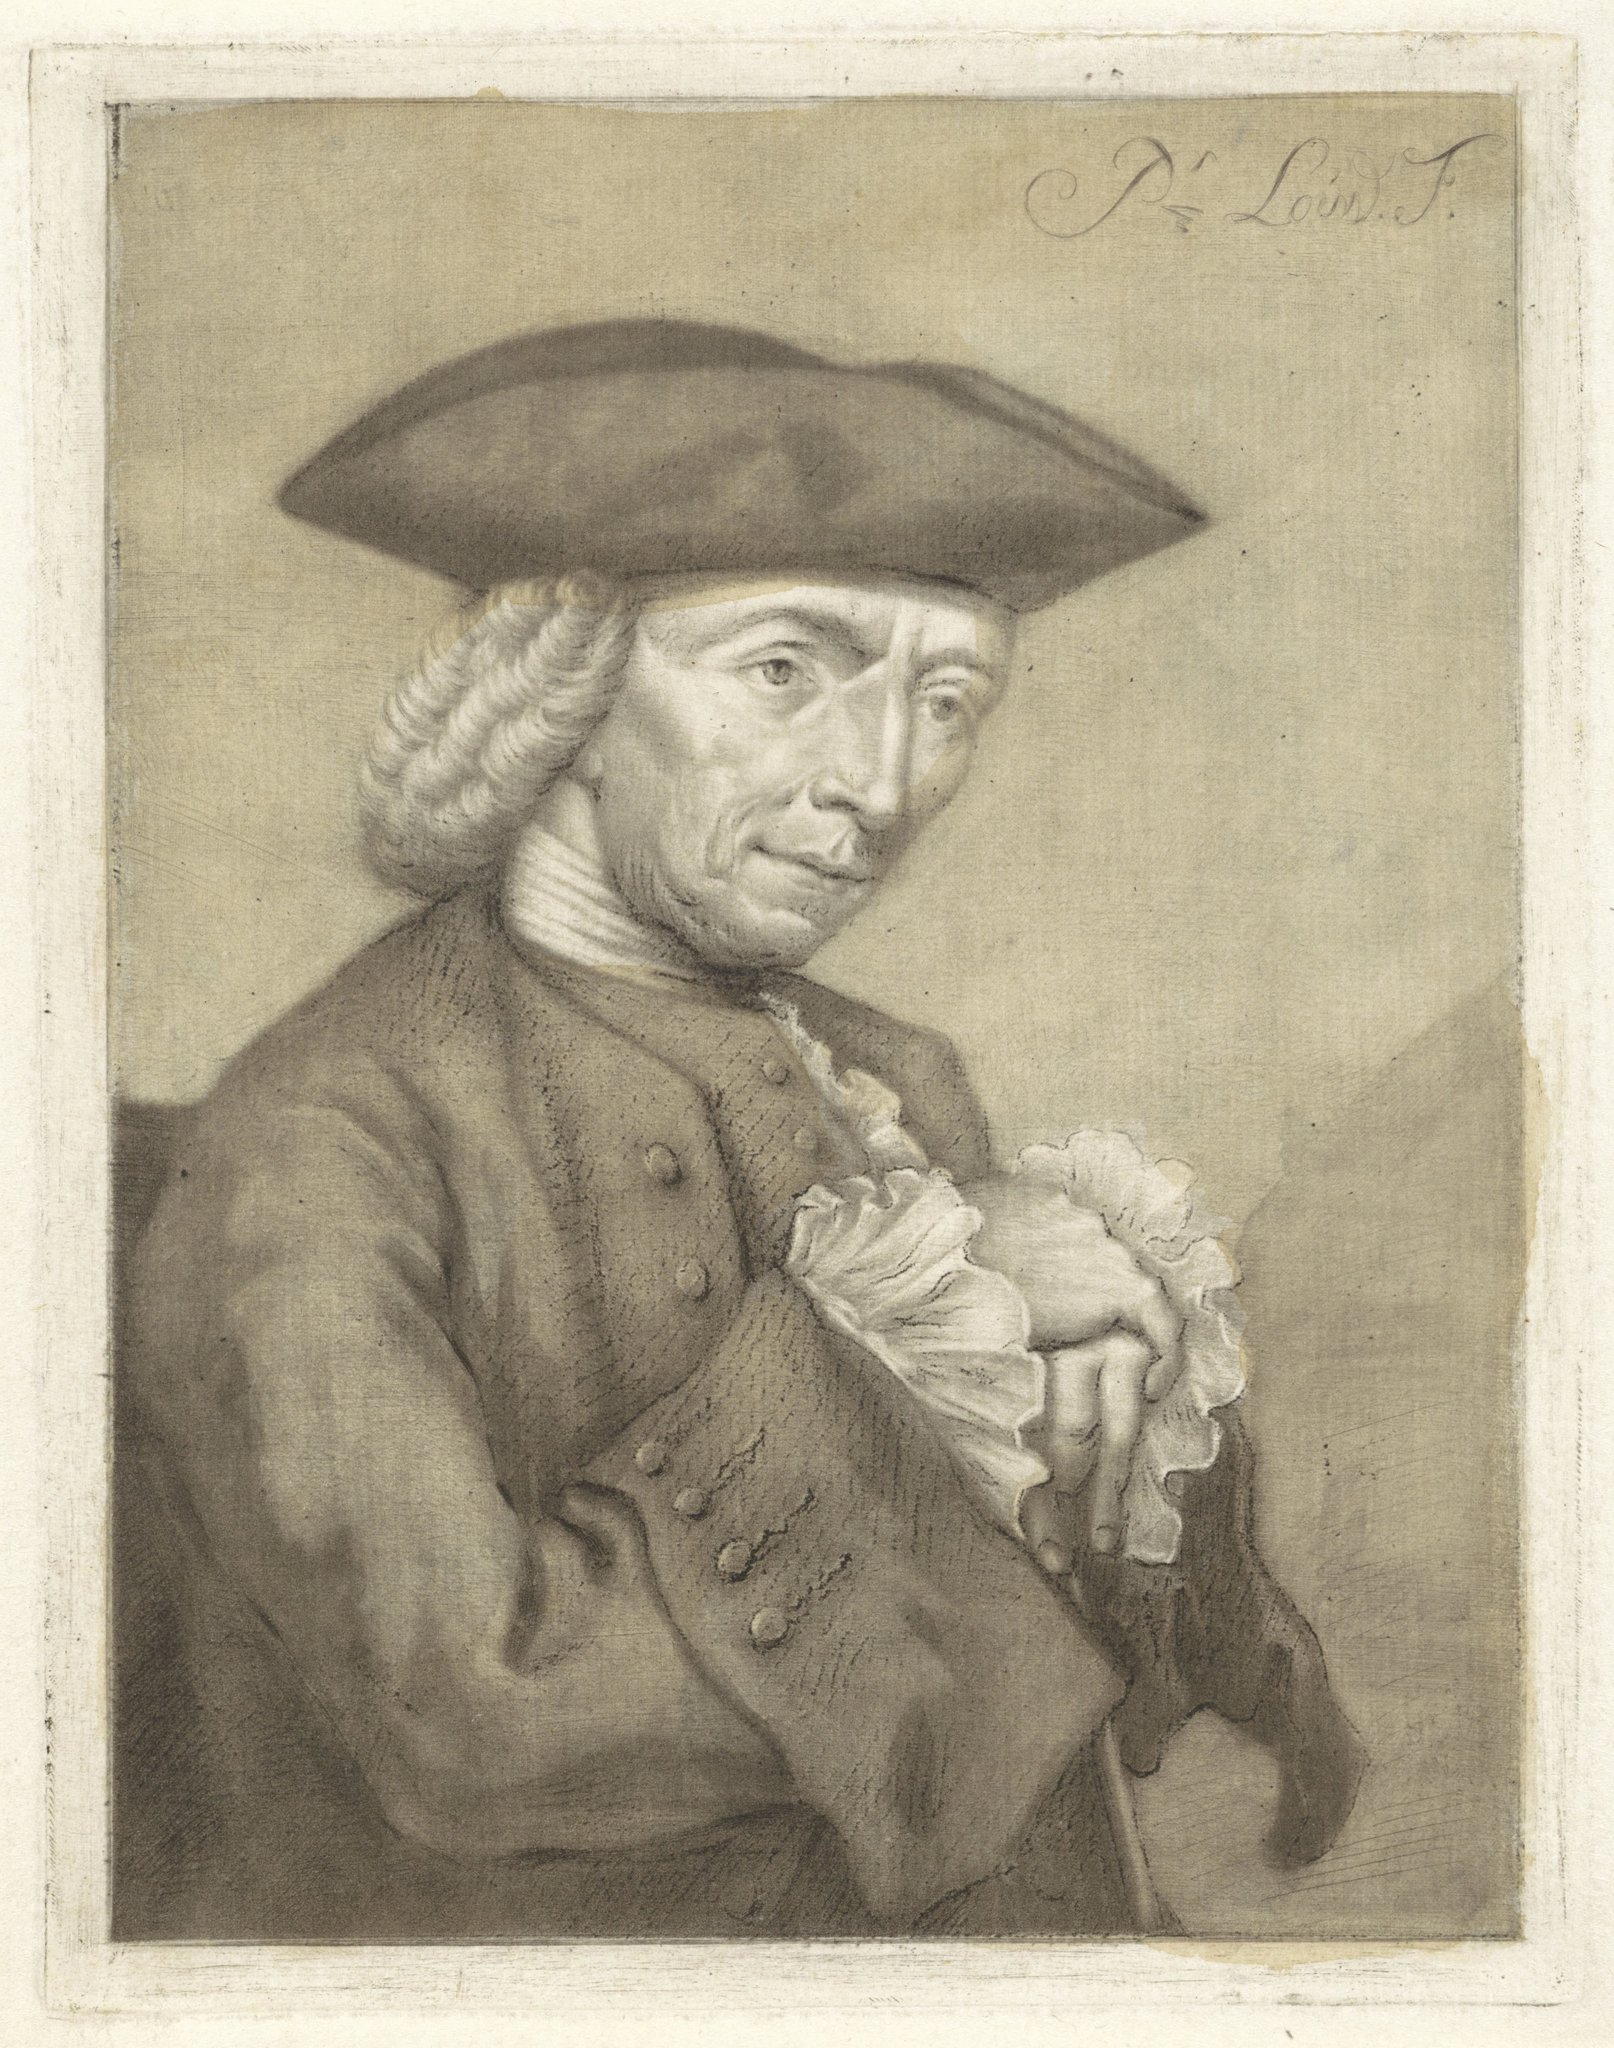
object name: print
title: Portret van Hendrik Spilman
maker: pieter louw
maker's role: draughtsman, print maker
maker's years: 1725-1800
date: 1743-1800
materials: paper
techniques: brush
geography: amsterdam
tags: haarlem, print maker, hendrik spilman, head-gear: hat (+ men's clothes), portrait, self-portrait of artist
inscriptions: collector's mark: Lugt 2228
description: De prentmaker, tekenaar en schilder Hendrik Spilman. Hij laat zijn over elkaar gevouwen handen op zijn wandelstok rusten.